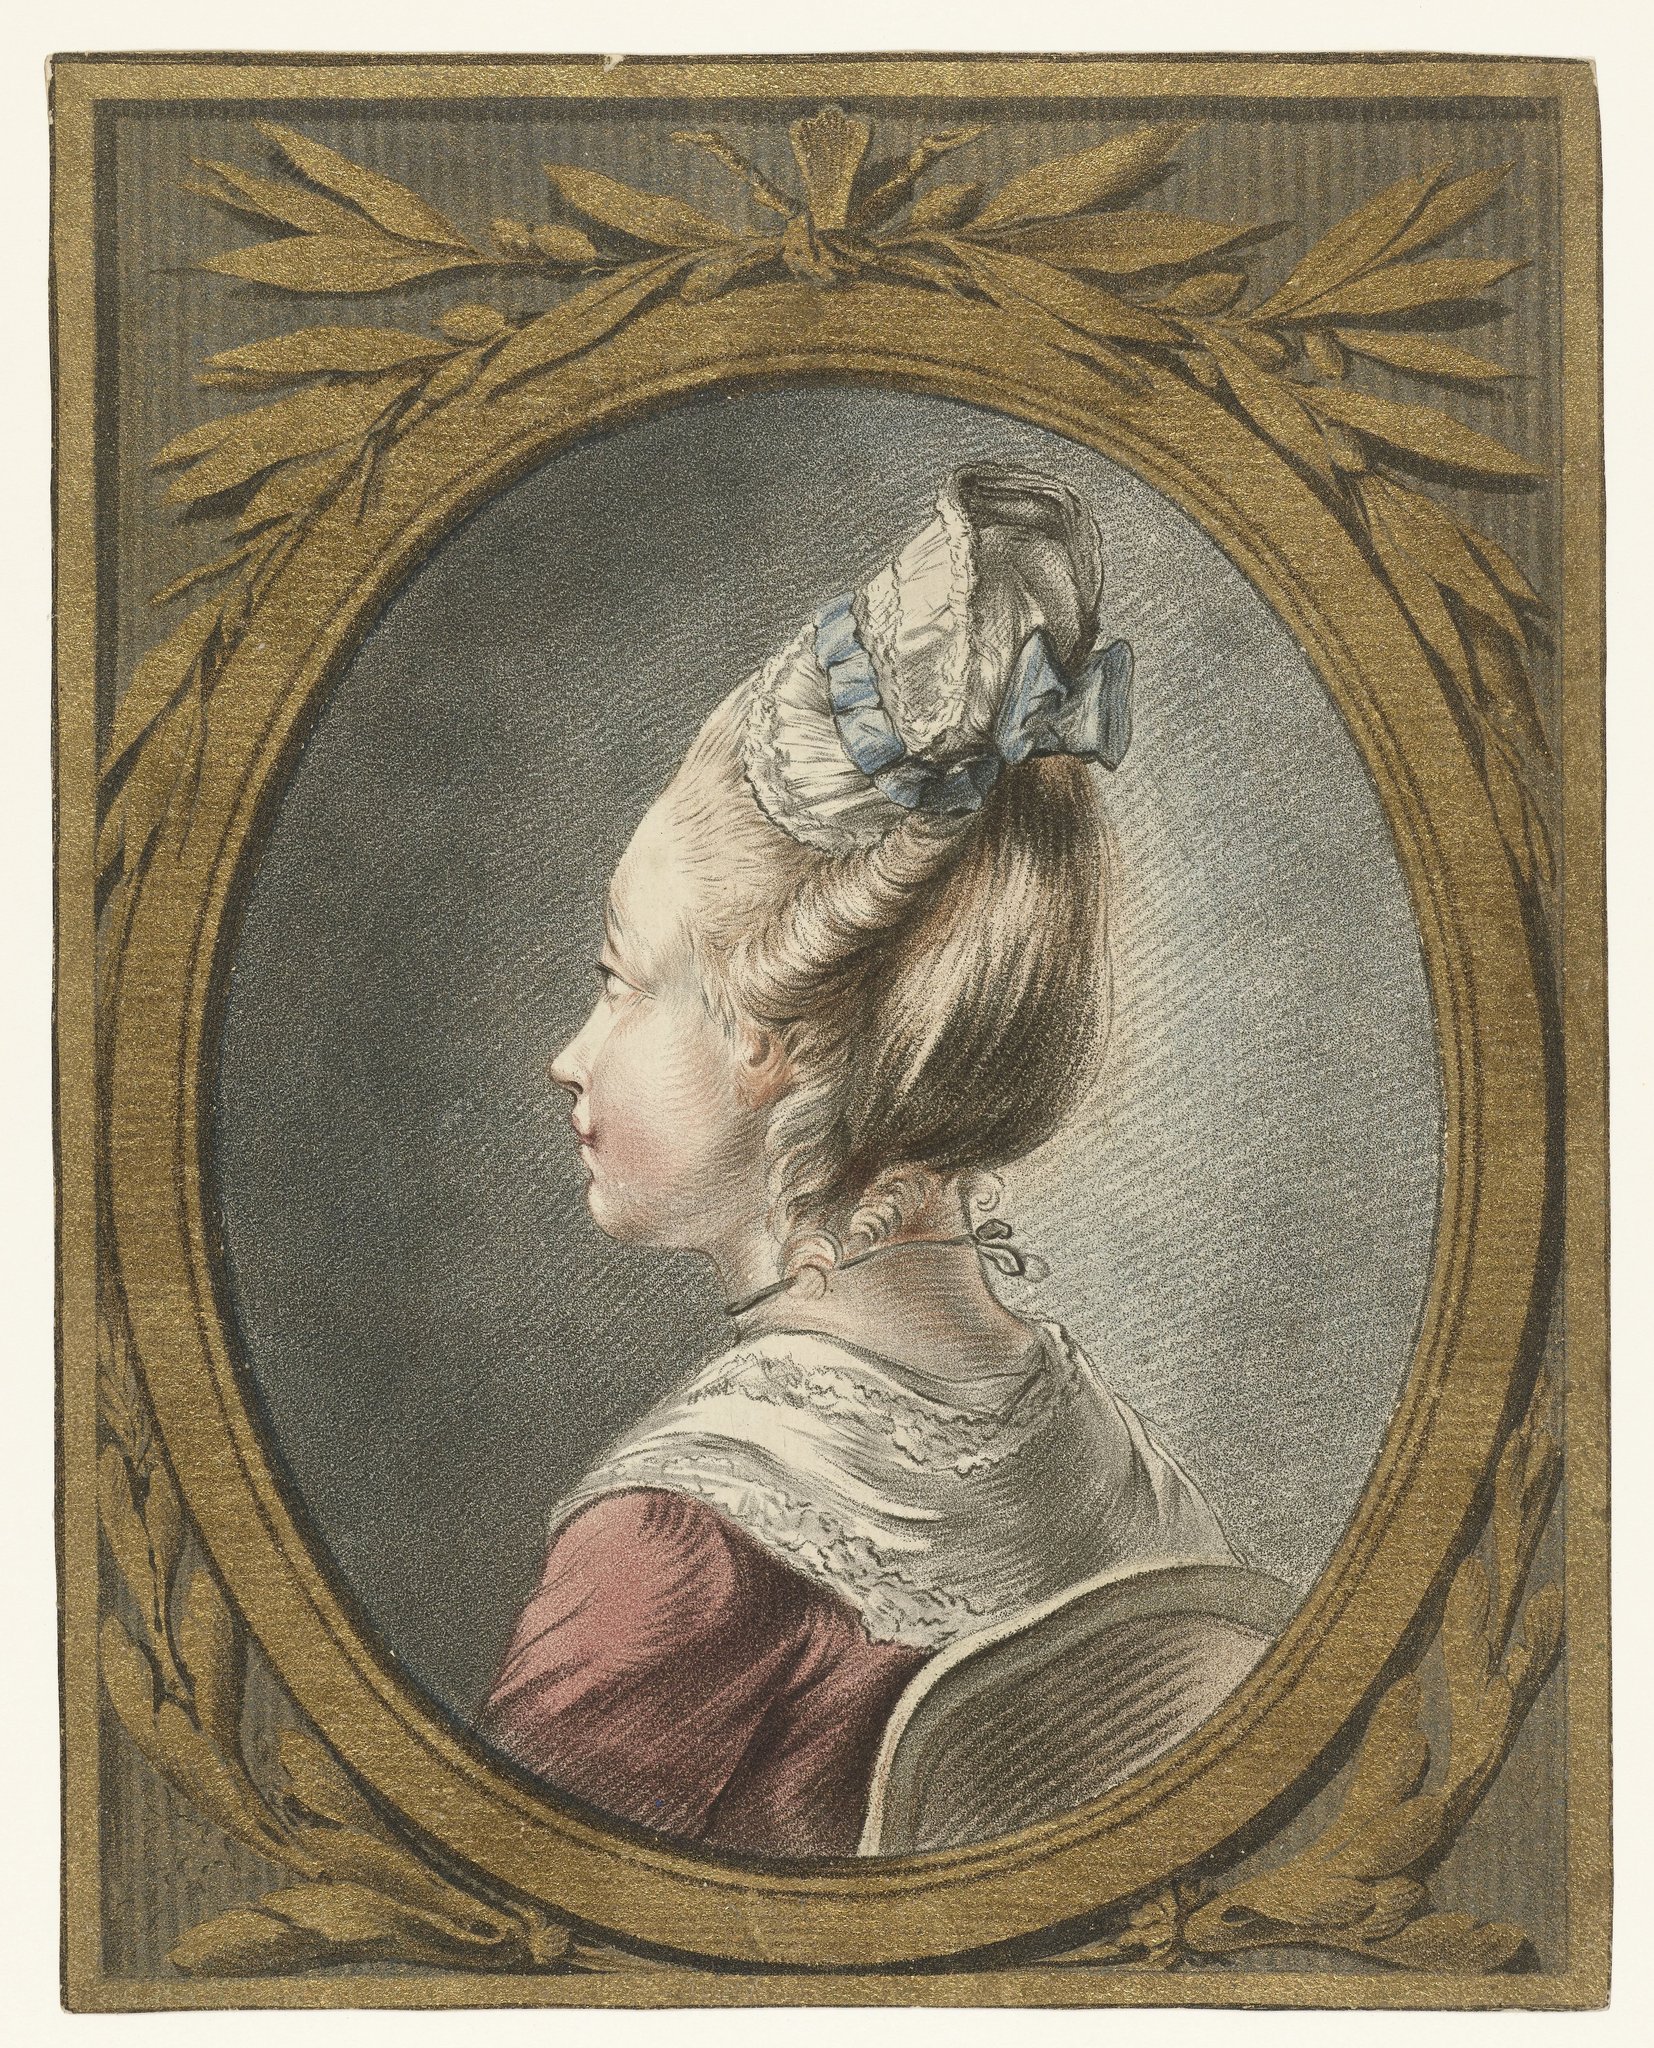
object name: print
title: Tête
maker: louis marin bonnet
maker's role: print maker, publisher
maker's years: 1736-1793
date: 1774-1793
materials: paper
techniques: printing, drawing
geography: paris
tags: adolescent, young woman, maiden (+ sideview, profile)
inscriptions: collector's mark: Lugt 2760, collector's mark: Lugt 2228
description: De pastelmanier en deze goudbronsdruk zijn uitvindingen van Bonnet. Onder de voorstelling (bij deze prent afgesneden) stond: L'Invention de cette nouvelle manière de graver et Imprimer l'Or a été trouvée par Louis Marin et mise au jour le 16 Novembre 1774. A Paris chez Bonnet, rue St. Jacques au coin de celle de la parcheminerie au magazin Anglois. Botke, K.